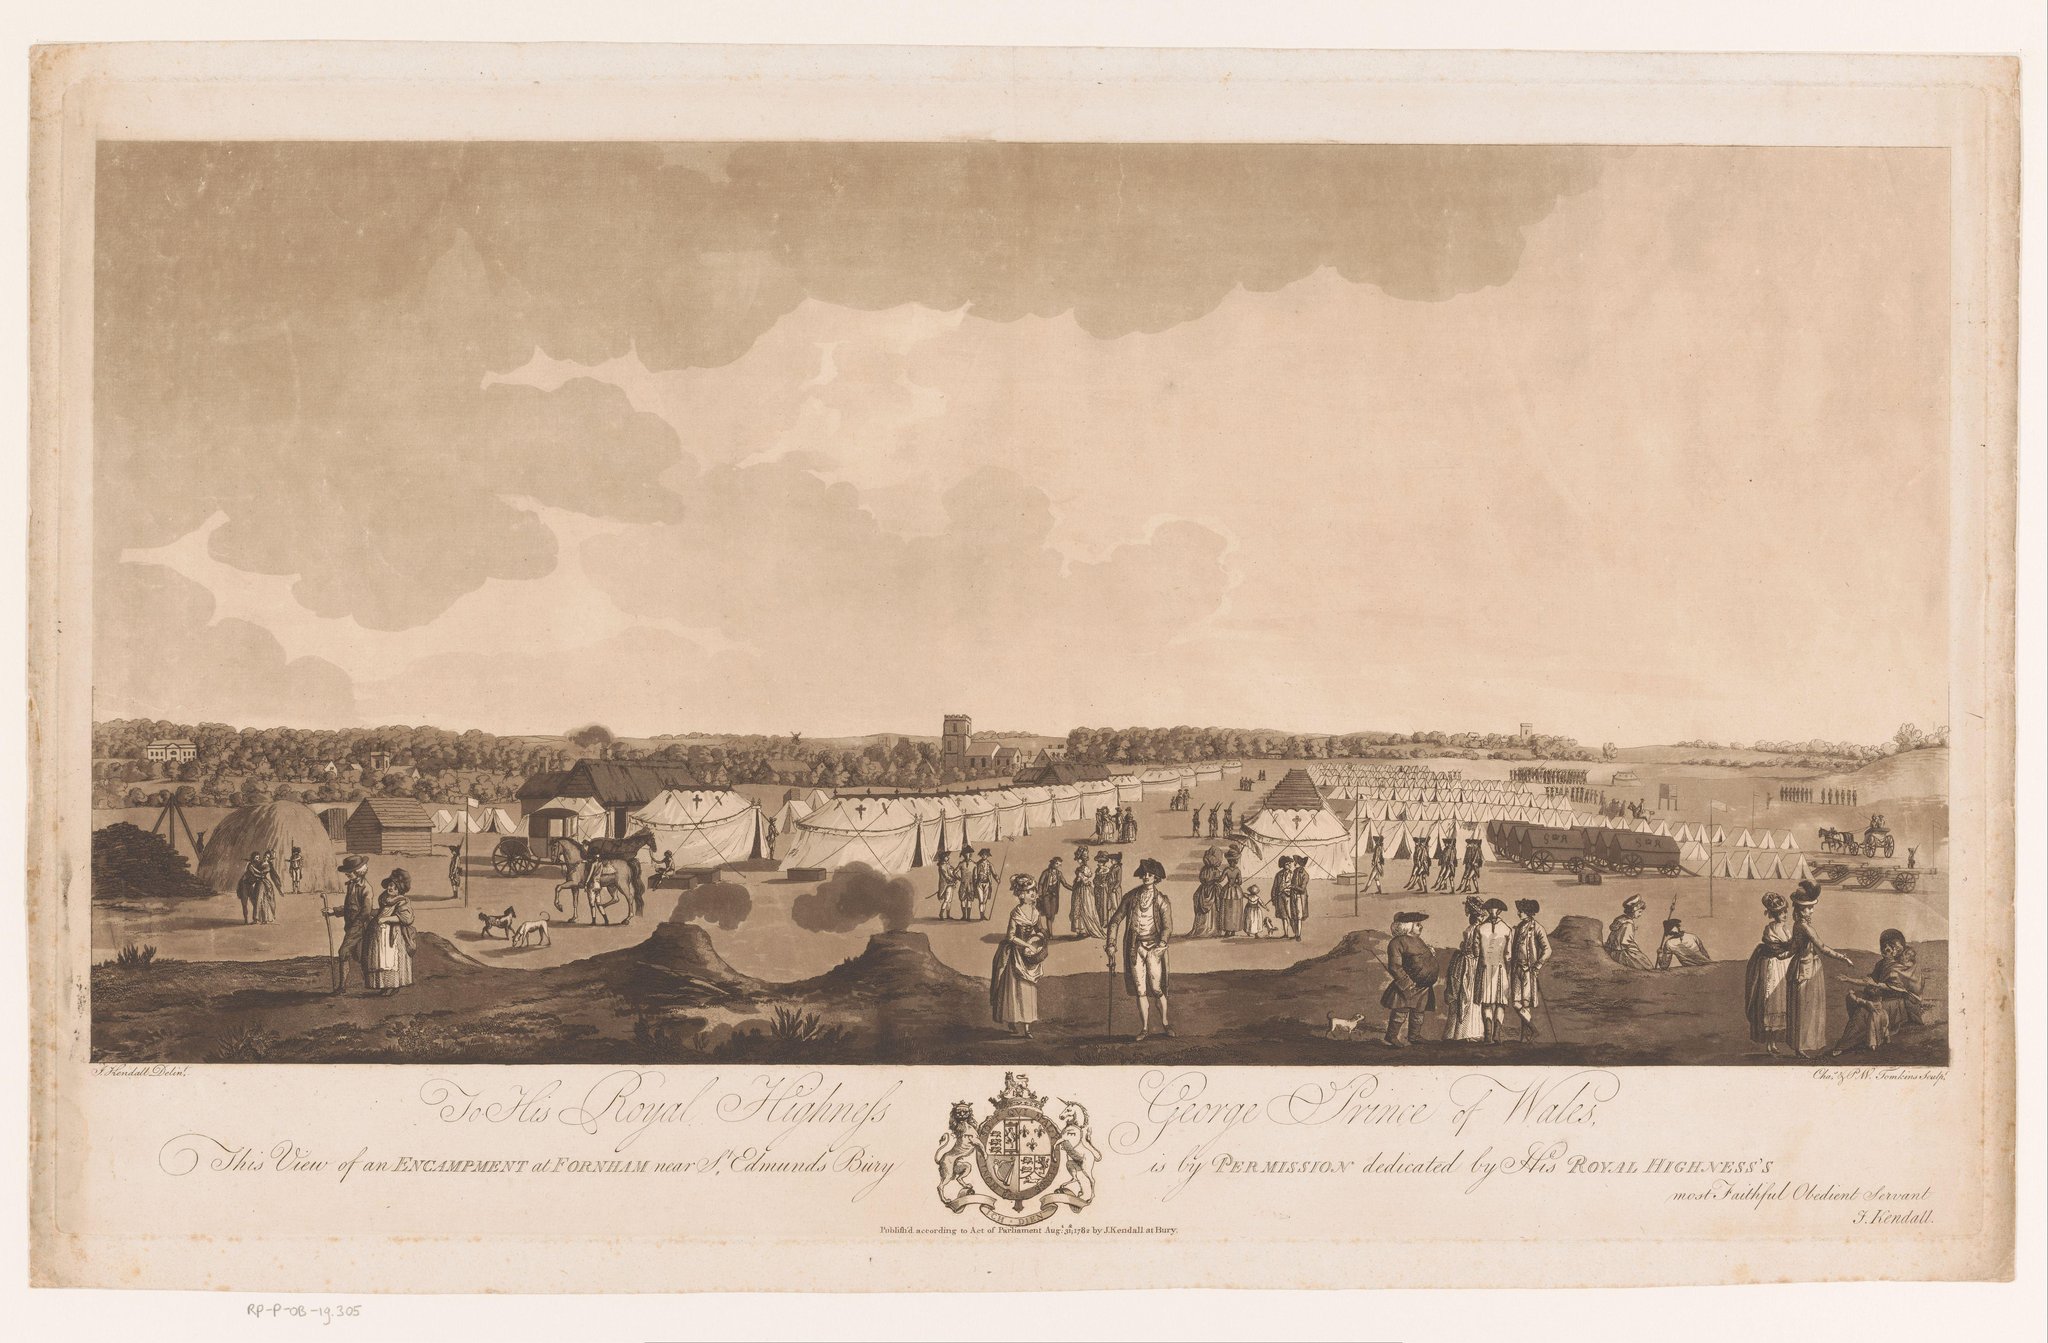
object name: print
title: View of an Encampment at Fornham near St. Edmunds Bury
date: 1708-1782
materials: paper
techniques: aquatint, etching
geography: bury saint edmunds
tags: (military) camp with tents, church (exterior), the soldier; the soldier's life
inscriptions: collector's mark: Lugt 2228